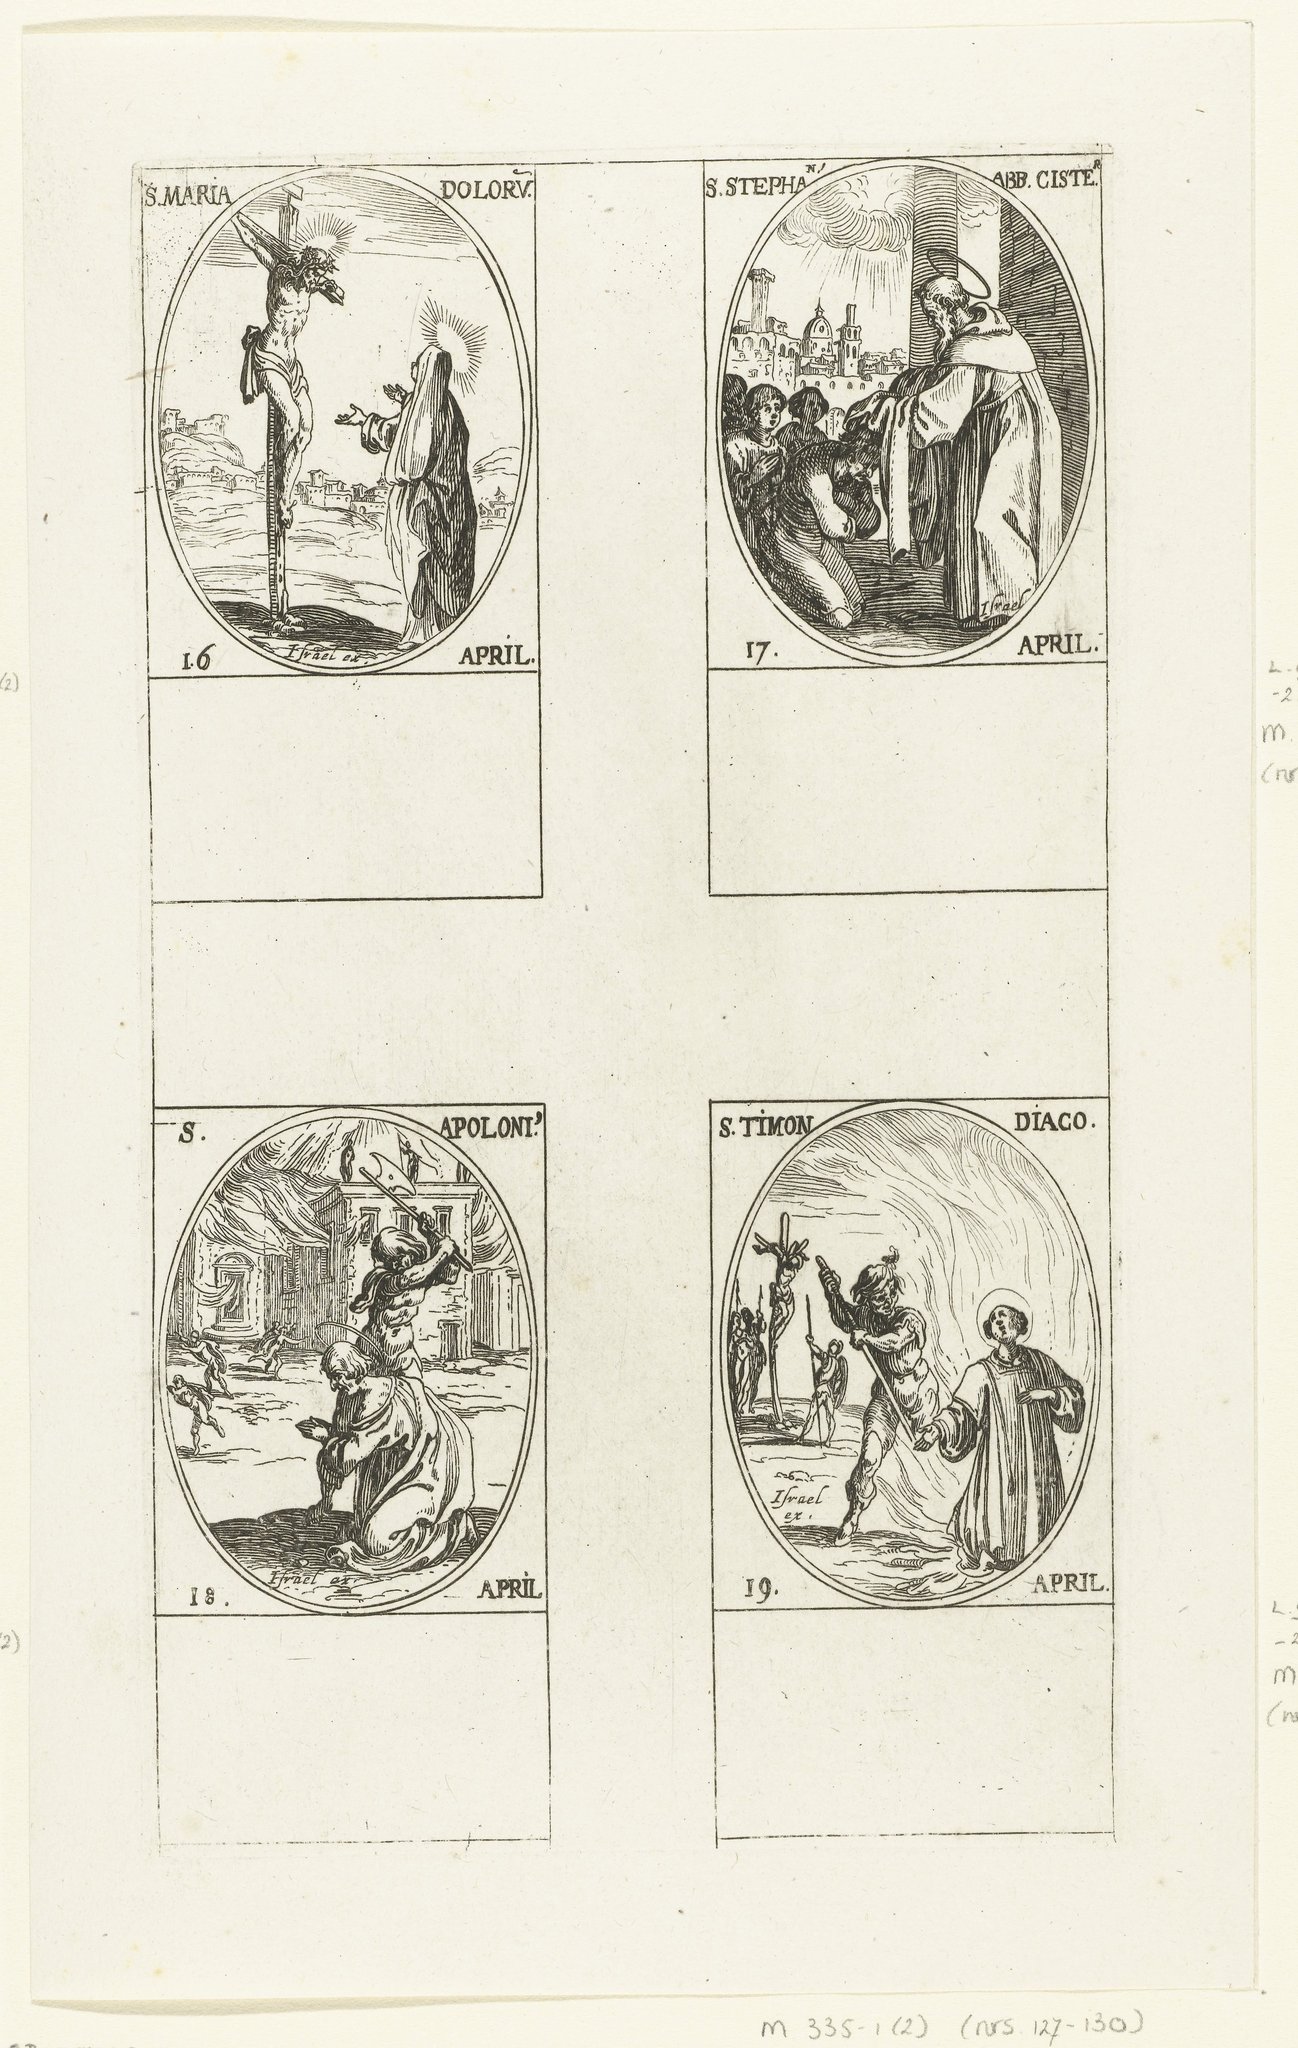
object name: print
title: Alle heiligen en de Christelijke feestdagen van het jaar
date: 1632-1636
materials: paper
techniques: etching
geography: paris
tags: crucified christ, with particular persons under the cross, adult christ with mary, male saints (with name)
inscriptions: collector's mark: Lugt 240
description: Blad met vier ovale voorstellingen, elk met opschrift en datum in het Latijn: linksboven Maria bij het kruis waaraan haar zoon Christus hangt, rechtsboven de Heilige Stephanus Harding die kleding uitdeelt, linksonder de Heilige Apollonius de Apologeet die onthoofd wordt, rechtsonder de Heilige Timon van Korinte die levend verbrand wordt. Deze prent is onderdeel van een serie prenten met voorstellingen van de heiligen en de christelijke feestdagen van het jaar. Er zijn steeds vier scènes van één plaat op één blad gedrukt. Inclusief bijbehorend titelblad en frontispice gaat het in totaal om 124 platen (490 voorstellingen). De drie platen met de laatste 12 scènes (de veranderlijke christelijke feestdagen) zijn in de derde staat versneden tot 12 kleine plaatjes, en met een apart titelblad uitgegeven.